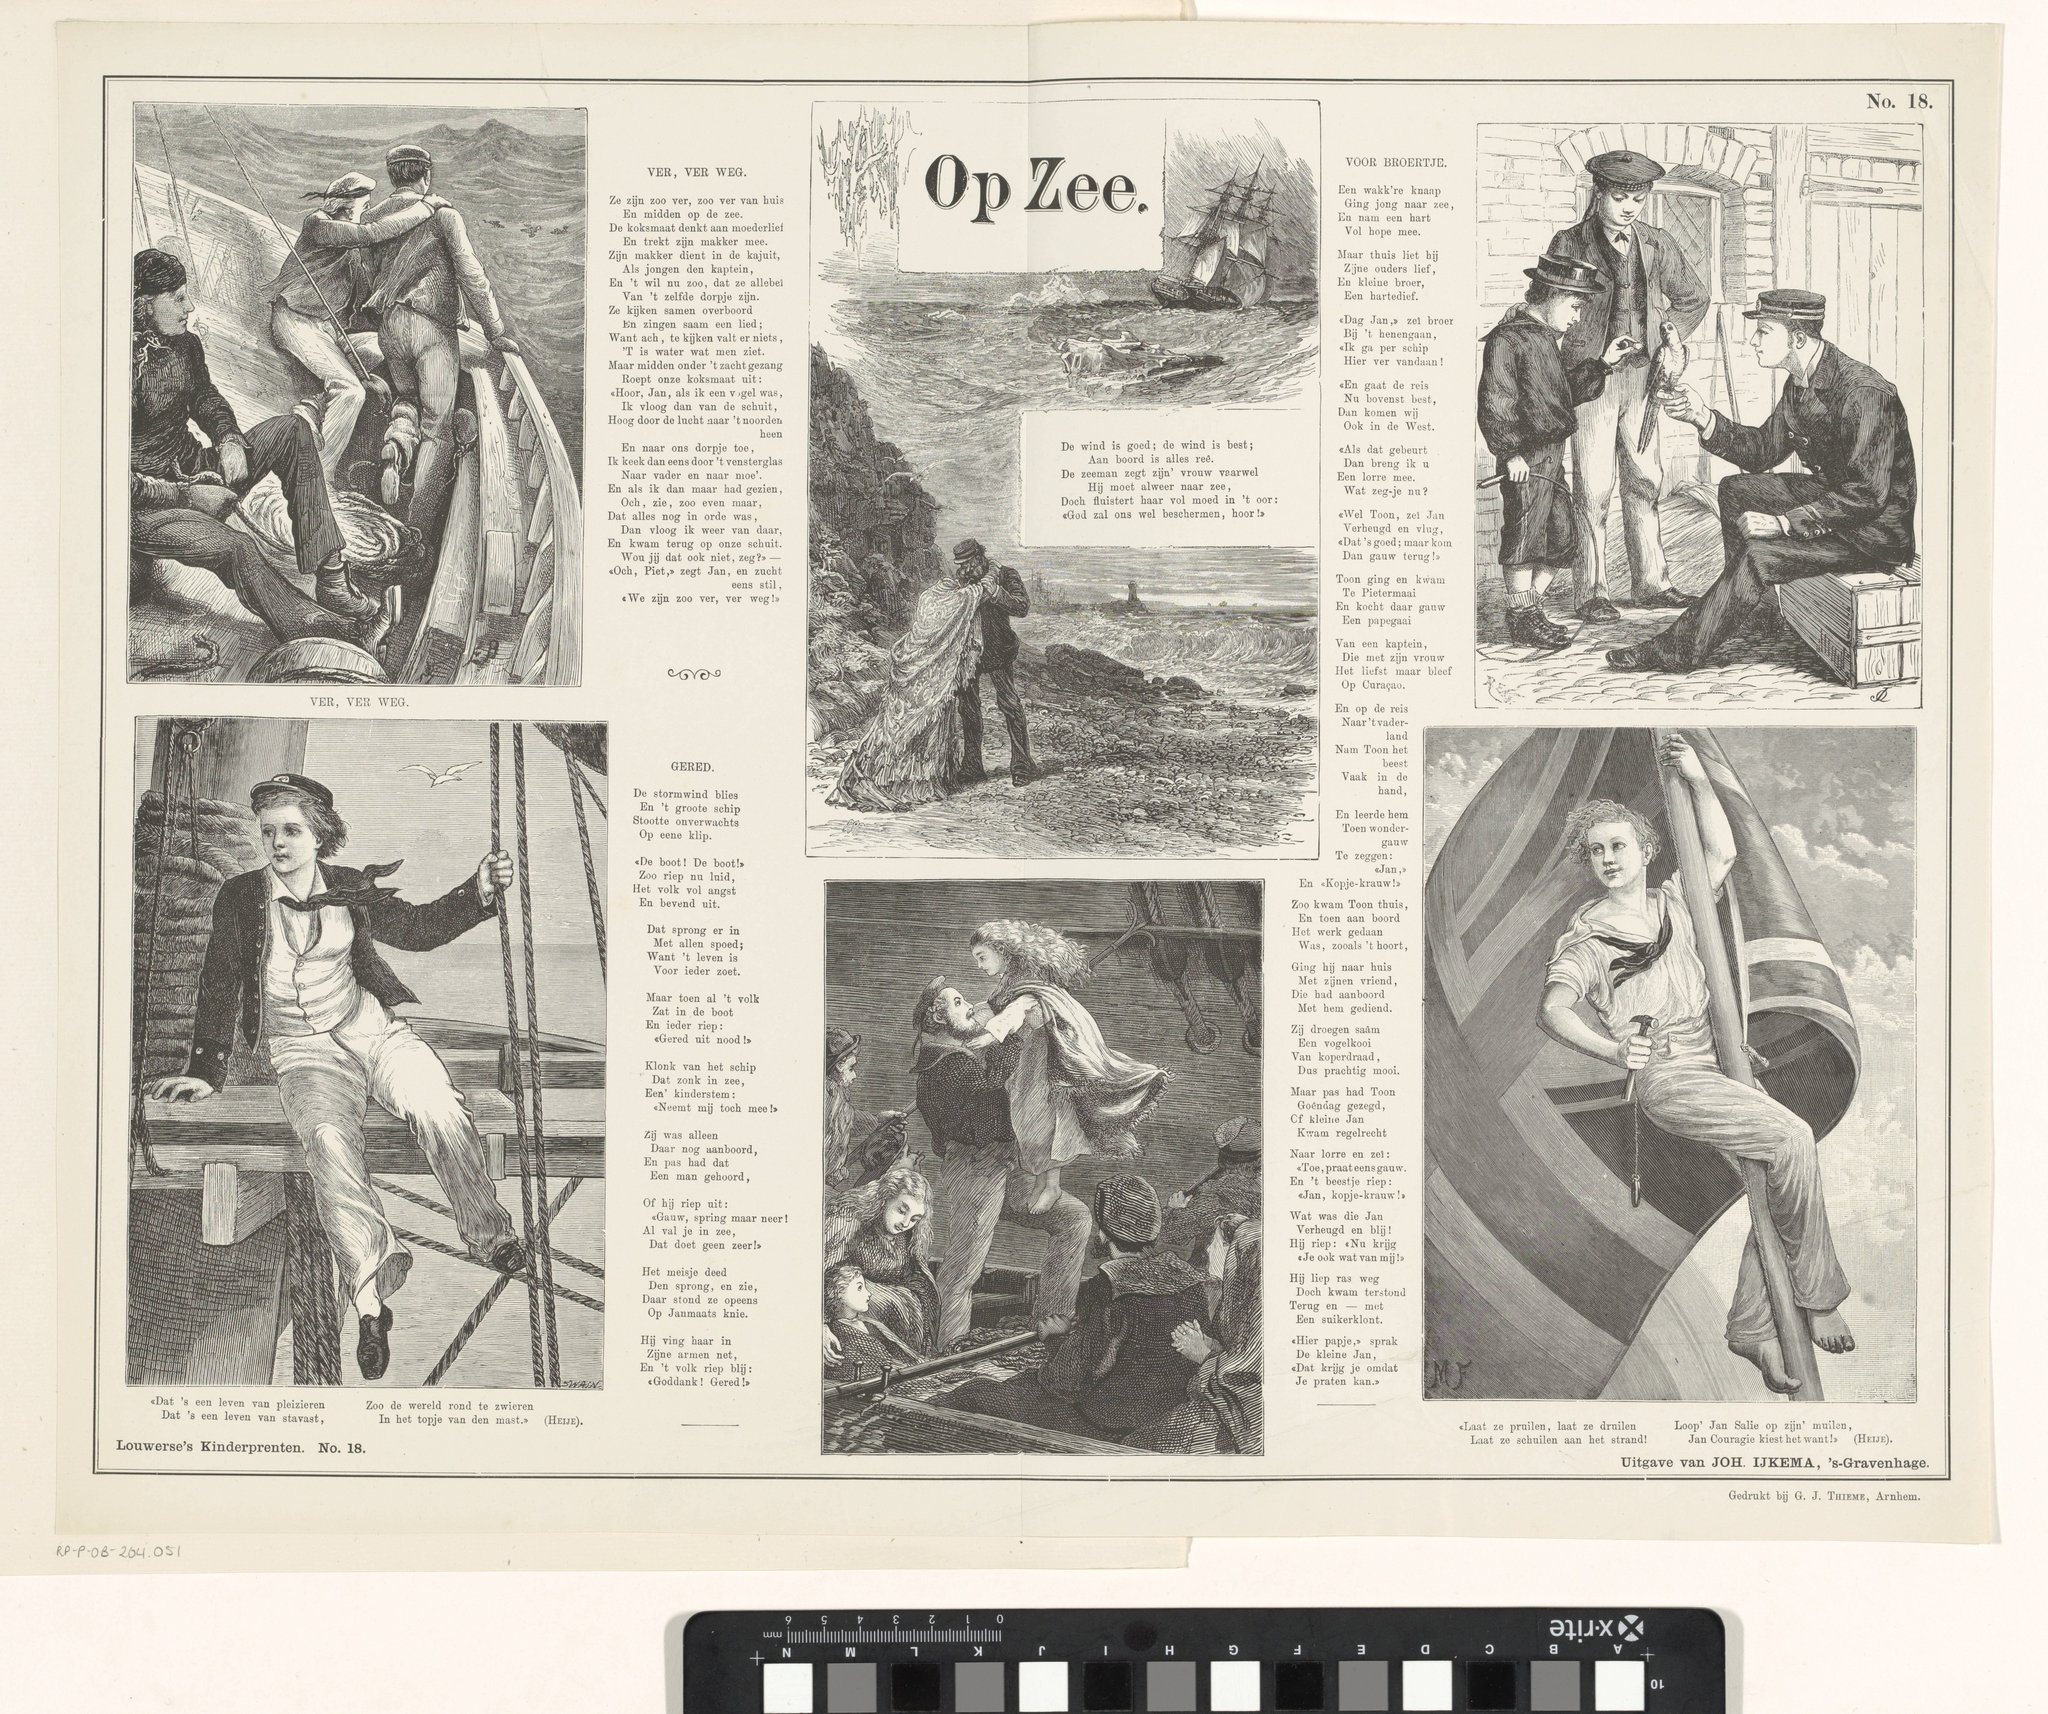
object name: popular print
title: Louwerse's kinderprenten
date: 1882-1905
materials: paper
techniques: letterpress printing, printing block, engraving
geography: the hague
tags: crew ~ ship, seaman, parts of ship's exterior: mast, seaman: sailor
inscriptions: collector's mark: Lugt 2760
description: Blad met 6 voorstellingen van zeelieden. Tussen de afbeeldingen versjes in boekdruk. Genummerd rechtsboven en linksonder: No. 18.